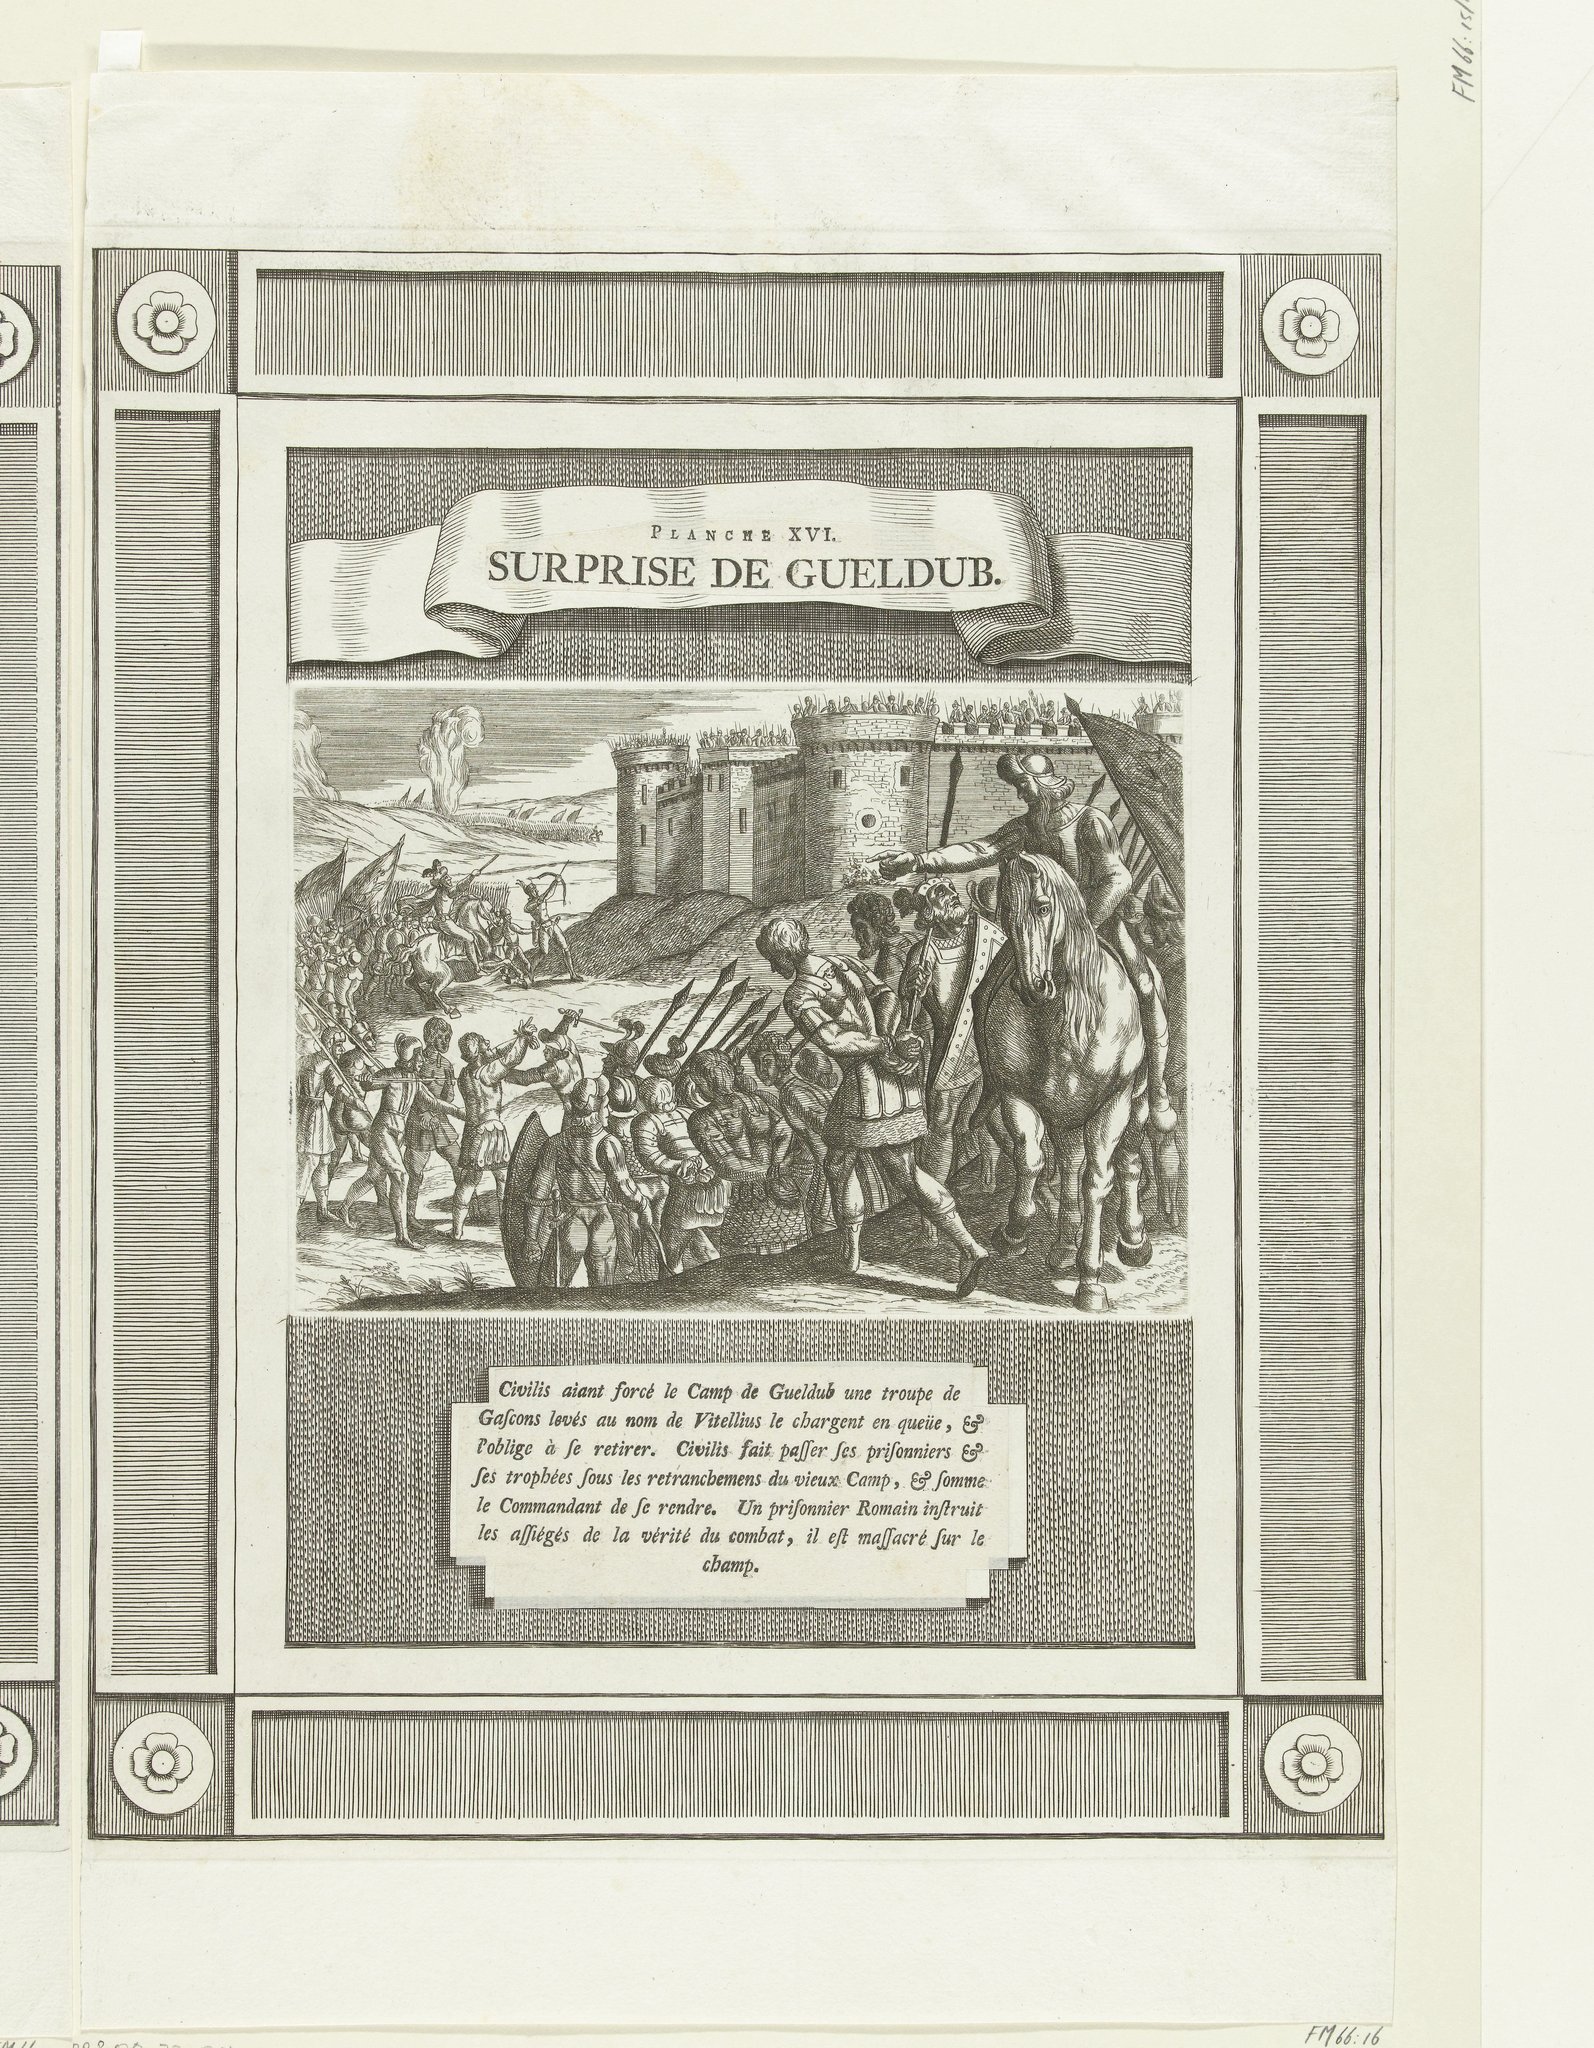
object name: print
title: Surprise de Gueldub / planche XVI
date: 1768-1770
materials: paper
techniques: engraving, etching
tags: battle, fighting in general, extinct, 'historical' peoples (with name), netherlands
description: Gevangengenomen Romeinse soldaten en vaandels worden langs de Romeinse vesting geleid. Prent 16 in een serie over de Bataafse Opstand, gekopieerd naar de reeks Batavorum cum Romanis bellum van Antonio Tempesta (Otto Vaenius, Antwerpen 1612). Illustratie voor: Marquis de St. Simon, Histoire de la guerre des Bataves et des Romains, d'après César; Corneille Tacite, Aux dépens de Marc-Michel Rey, Amsterdam 1770. Voorstellingen gedrukt in een grote ornamentele omlijsting waarin bovenaan een uitgeknipte titel en onderaan een onderschrift in het Frans is geplakt.